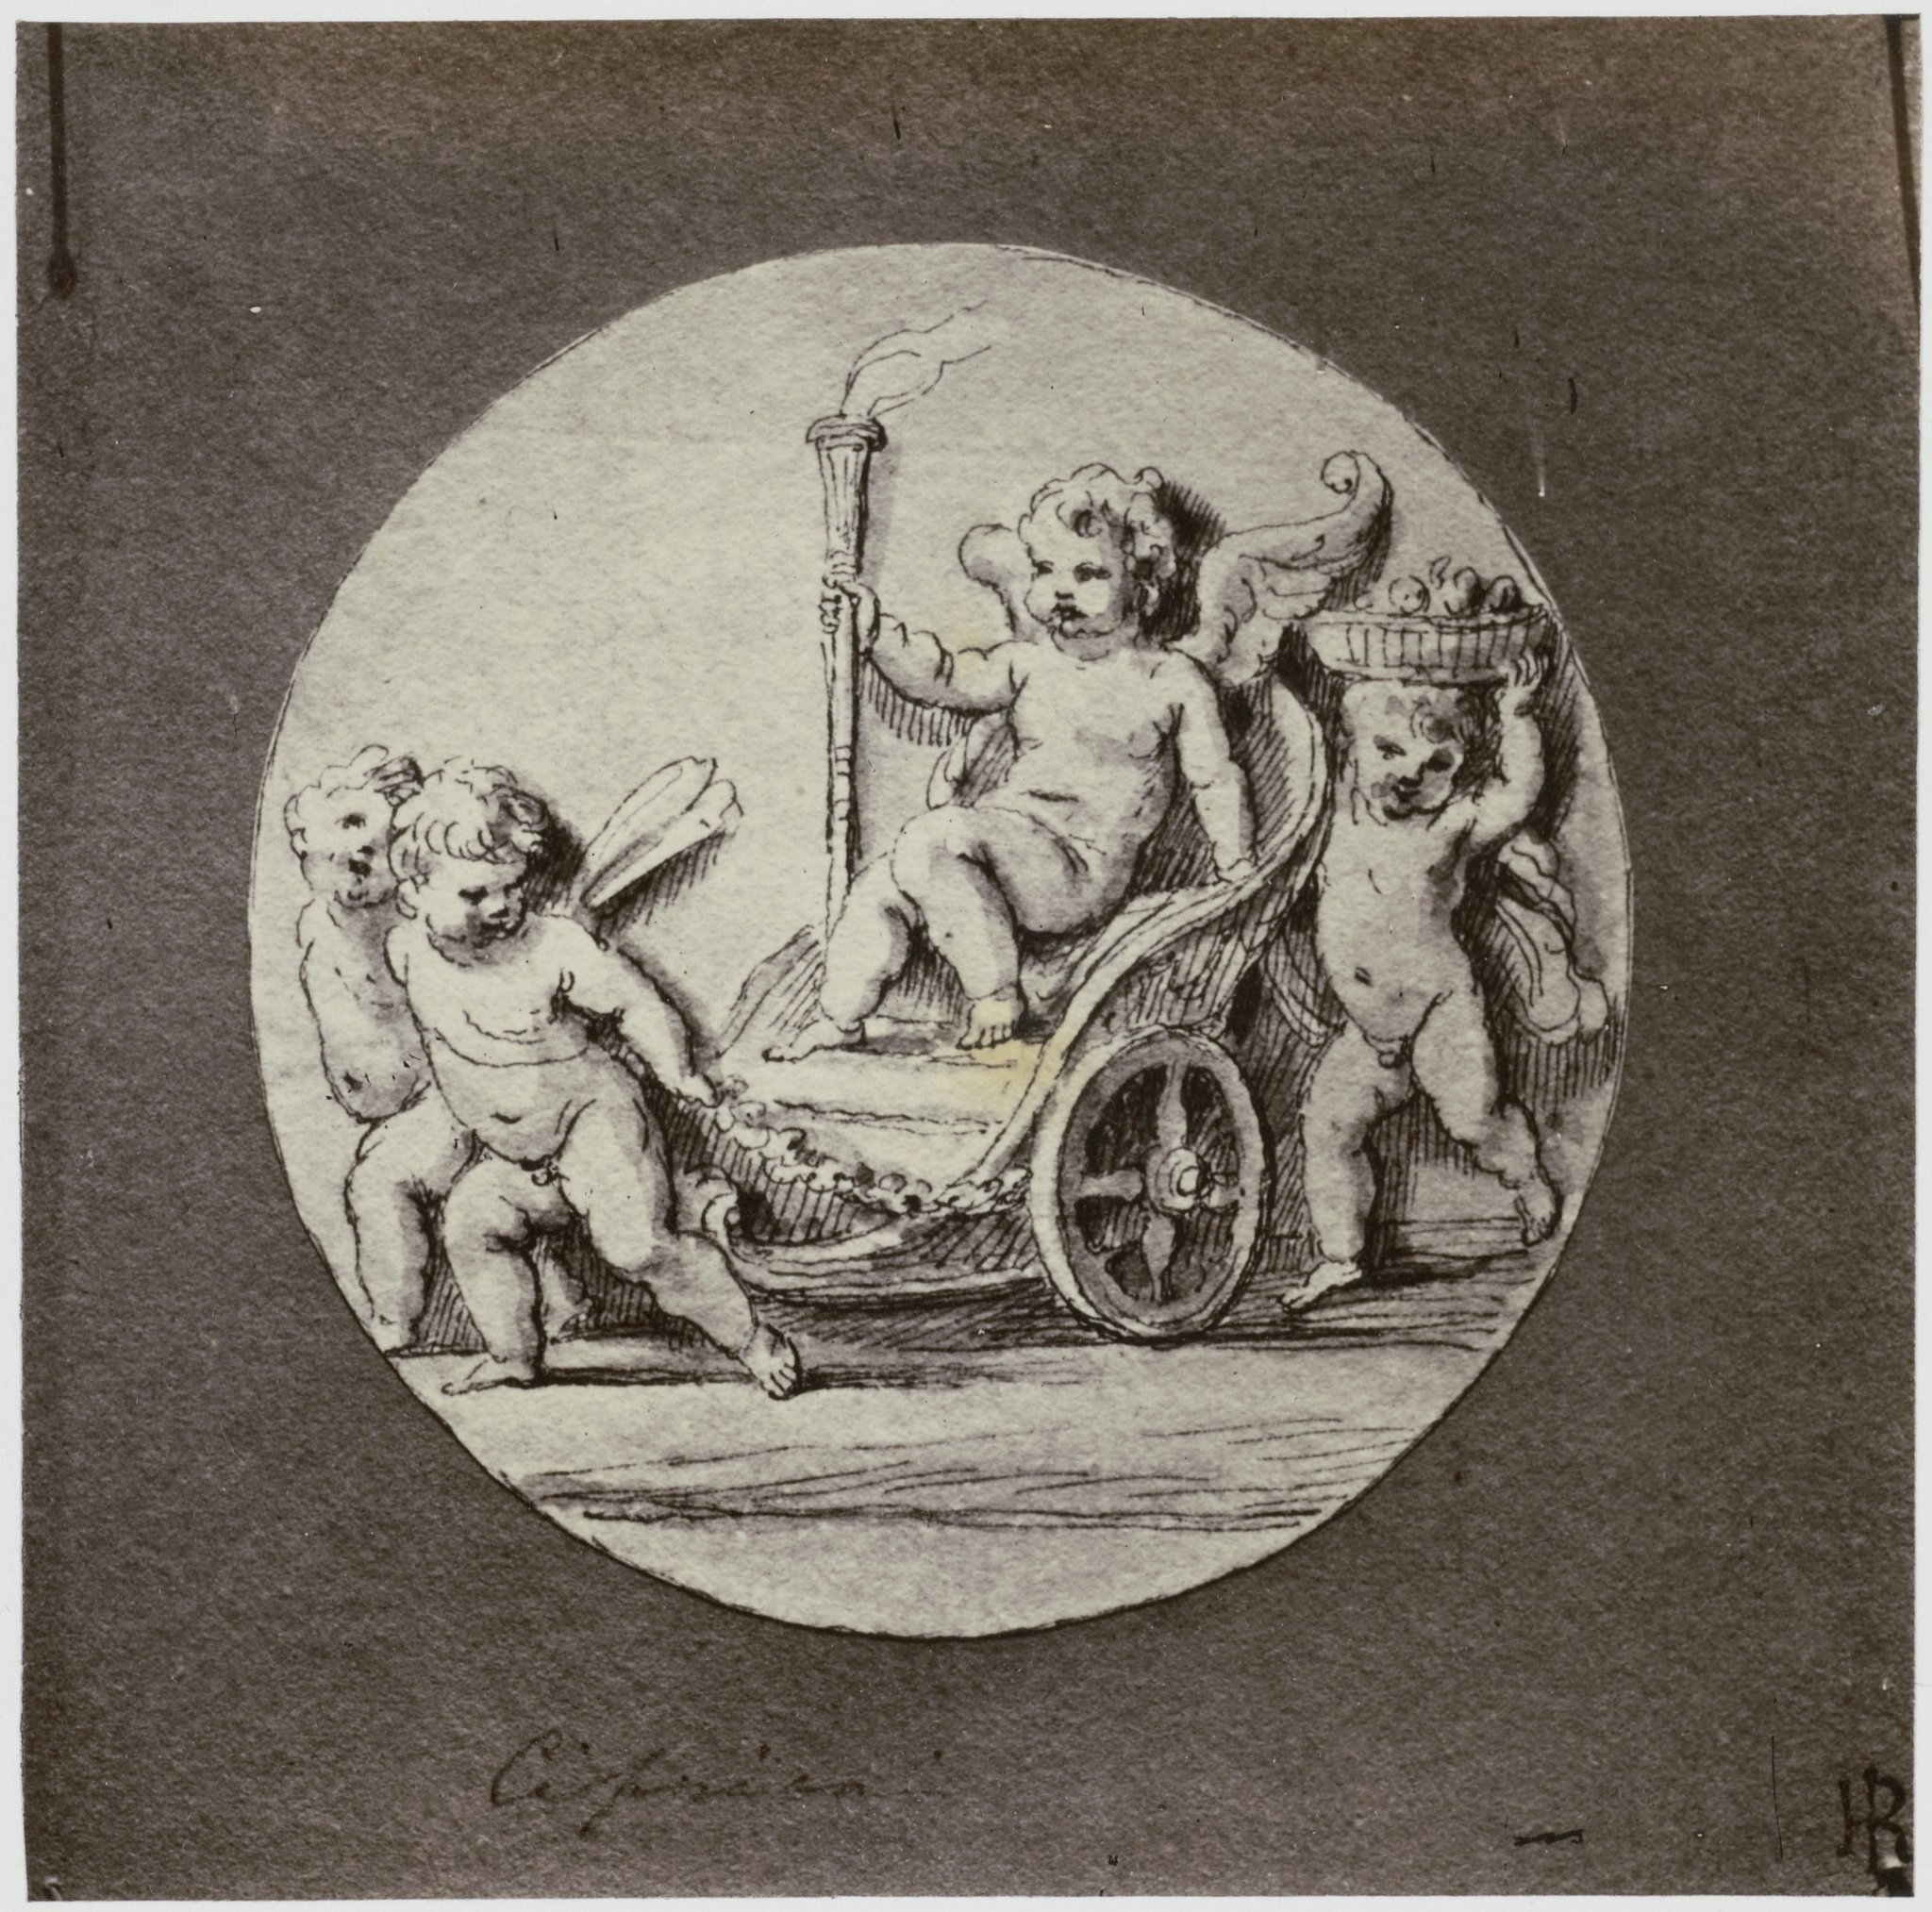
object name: photograph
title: Cipriani, The Triumph of Cupid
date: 1855-1858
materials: cardboard, paper, photographic support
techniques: albumen print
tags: drawing, sketch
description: Fotoreproductie van tekening in 'The Reveley Collection of Drawings at Brynygwin', afb. 56.